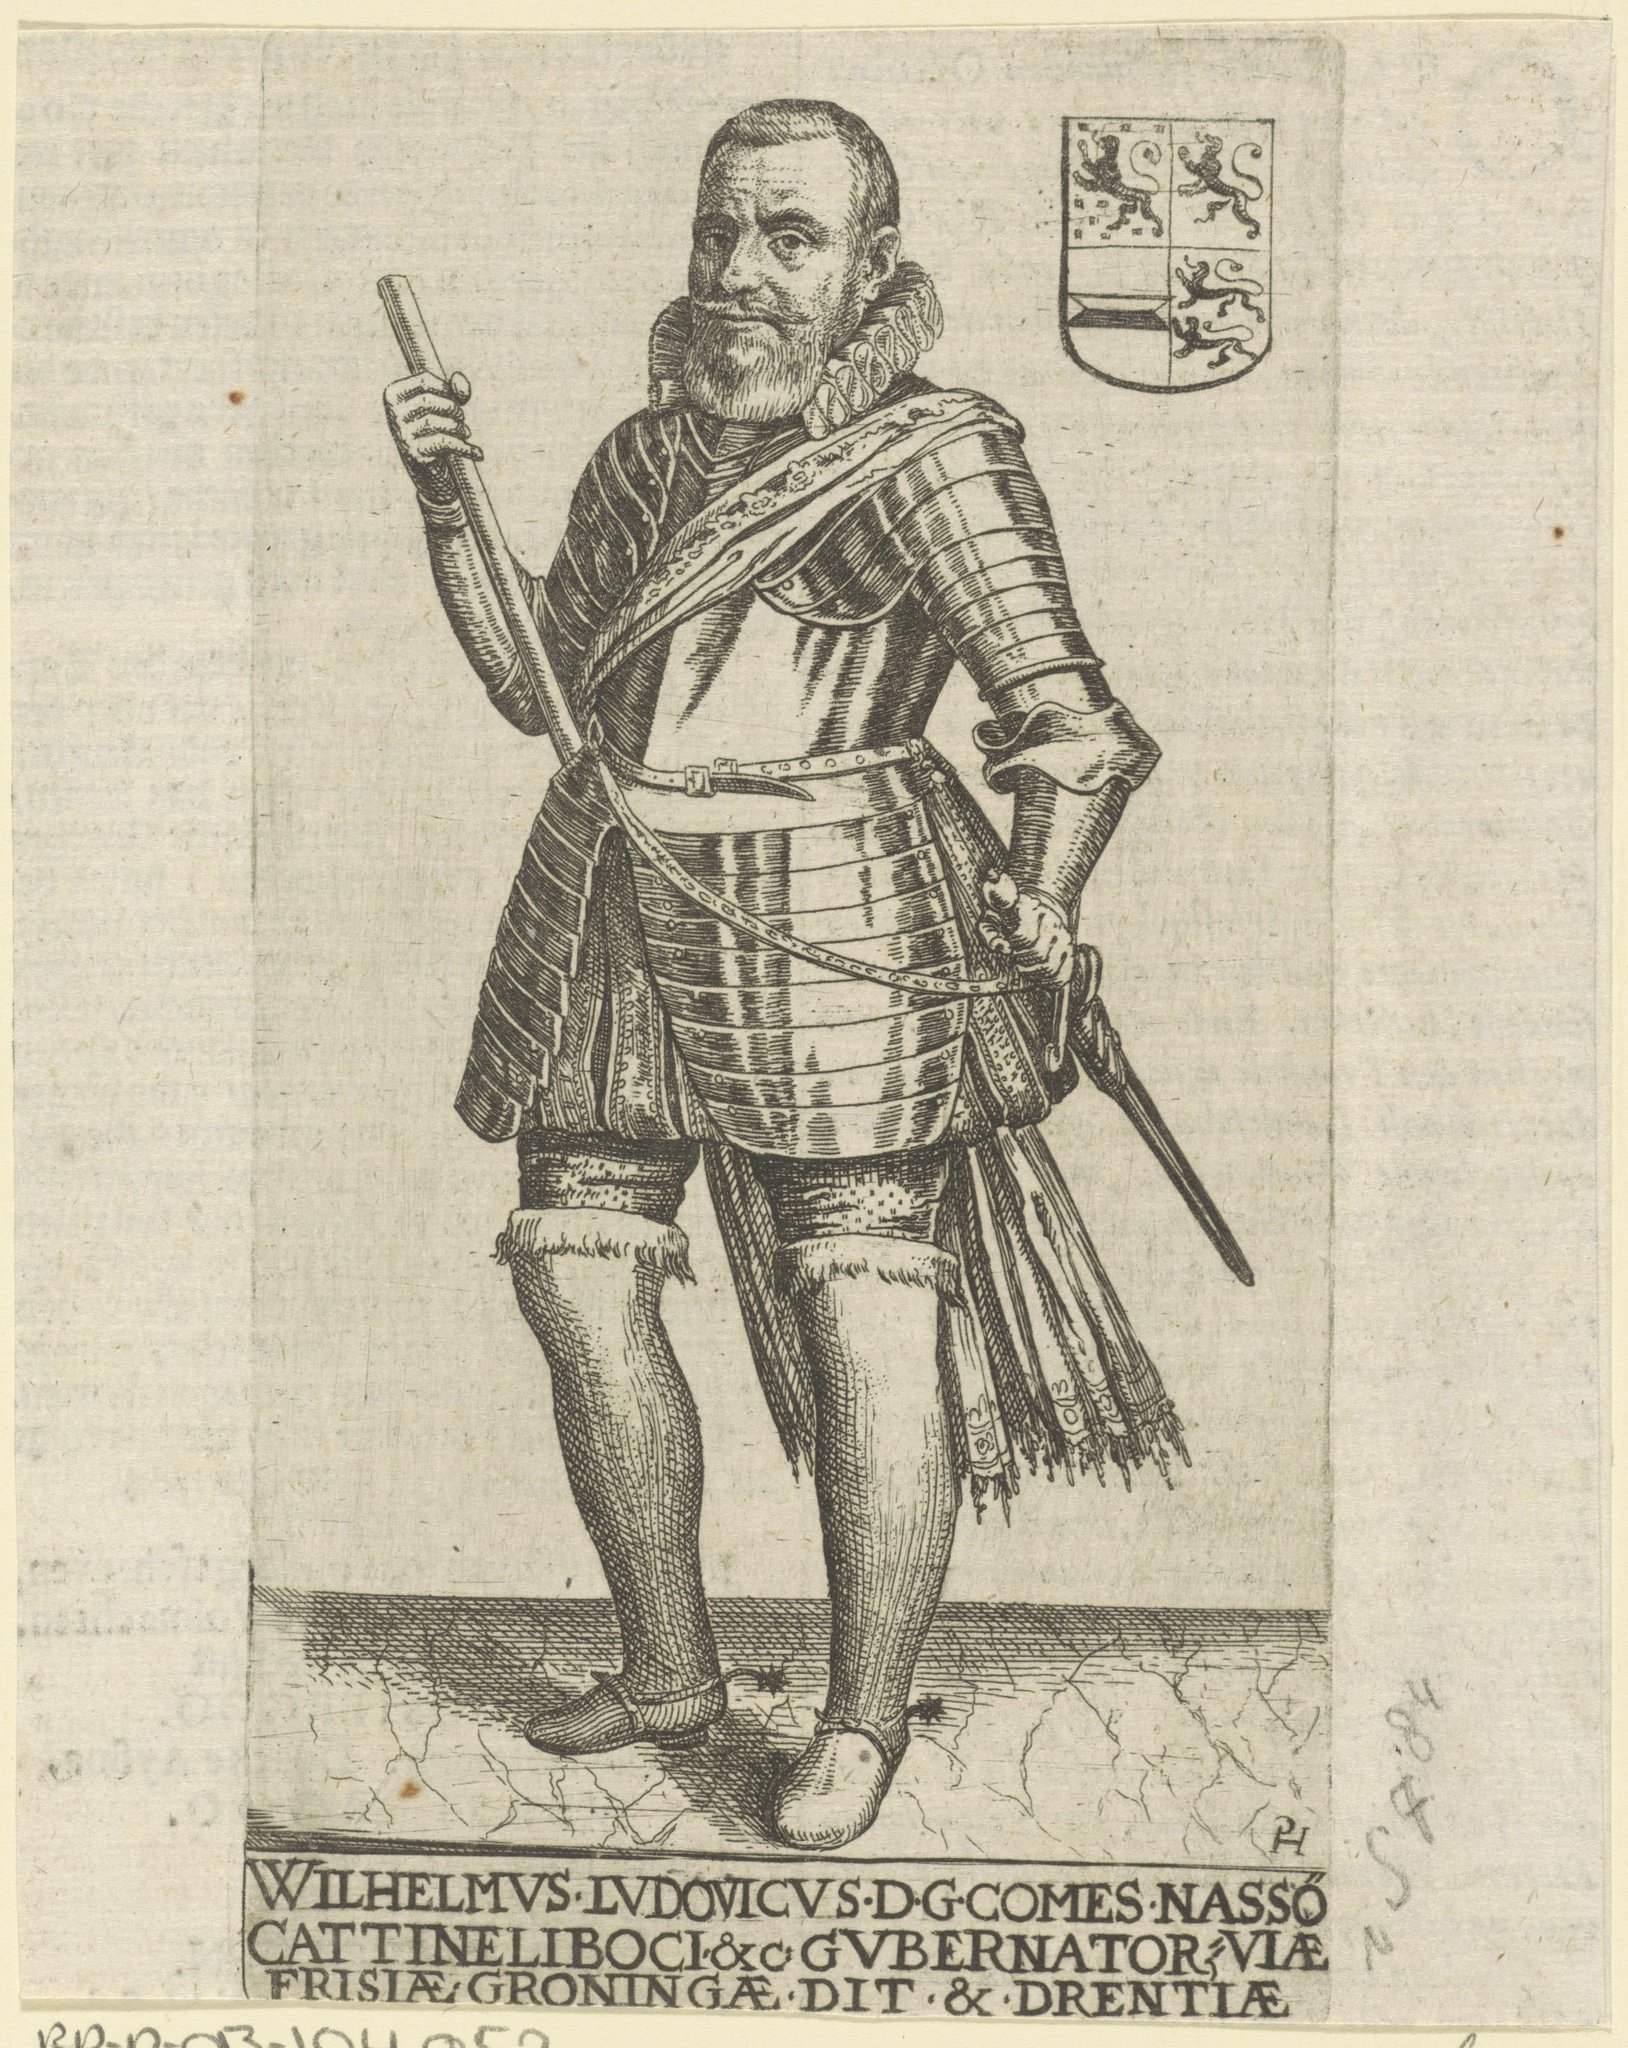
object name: book illustration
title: Portret van Willem Lodewijk, graaf van Nassau-Dillenburg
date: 1622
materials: paper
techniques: engraving, etching, letterpress printing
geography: franeker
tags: willem lodewijk graaf van nassau-dillenburg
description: De hier vermelde titel verwijst naar de hoogst verkregen titel van de geportretteerde, niet per se naar de titel die de geportretteerde op deze voorstelling draagt. Prent uit: Winsemius, Pierius. Chroniqve ofte historische geschiedenisse van Vrieslant. Franeker: Joannes Lamrinck, 1622.